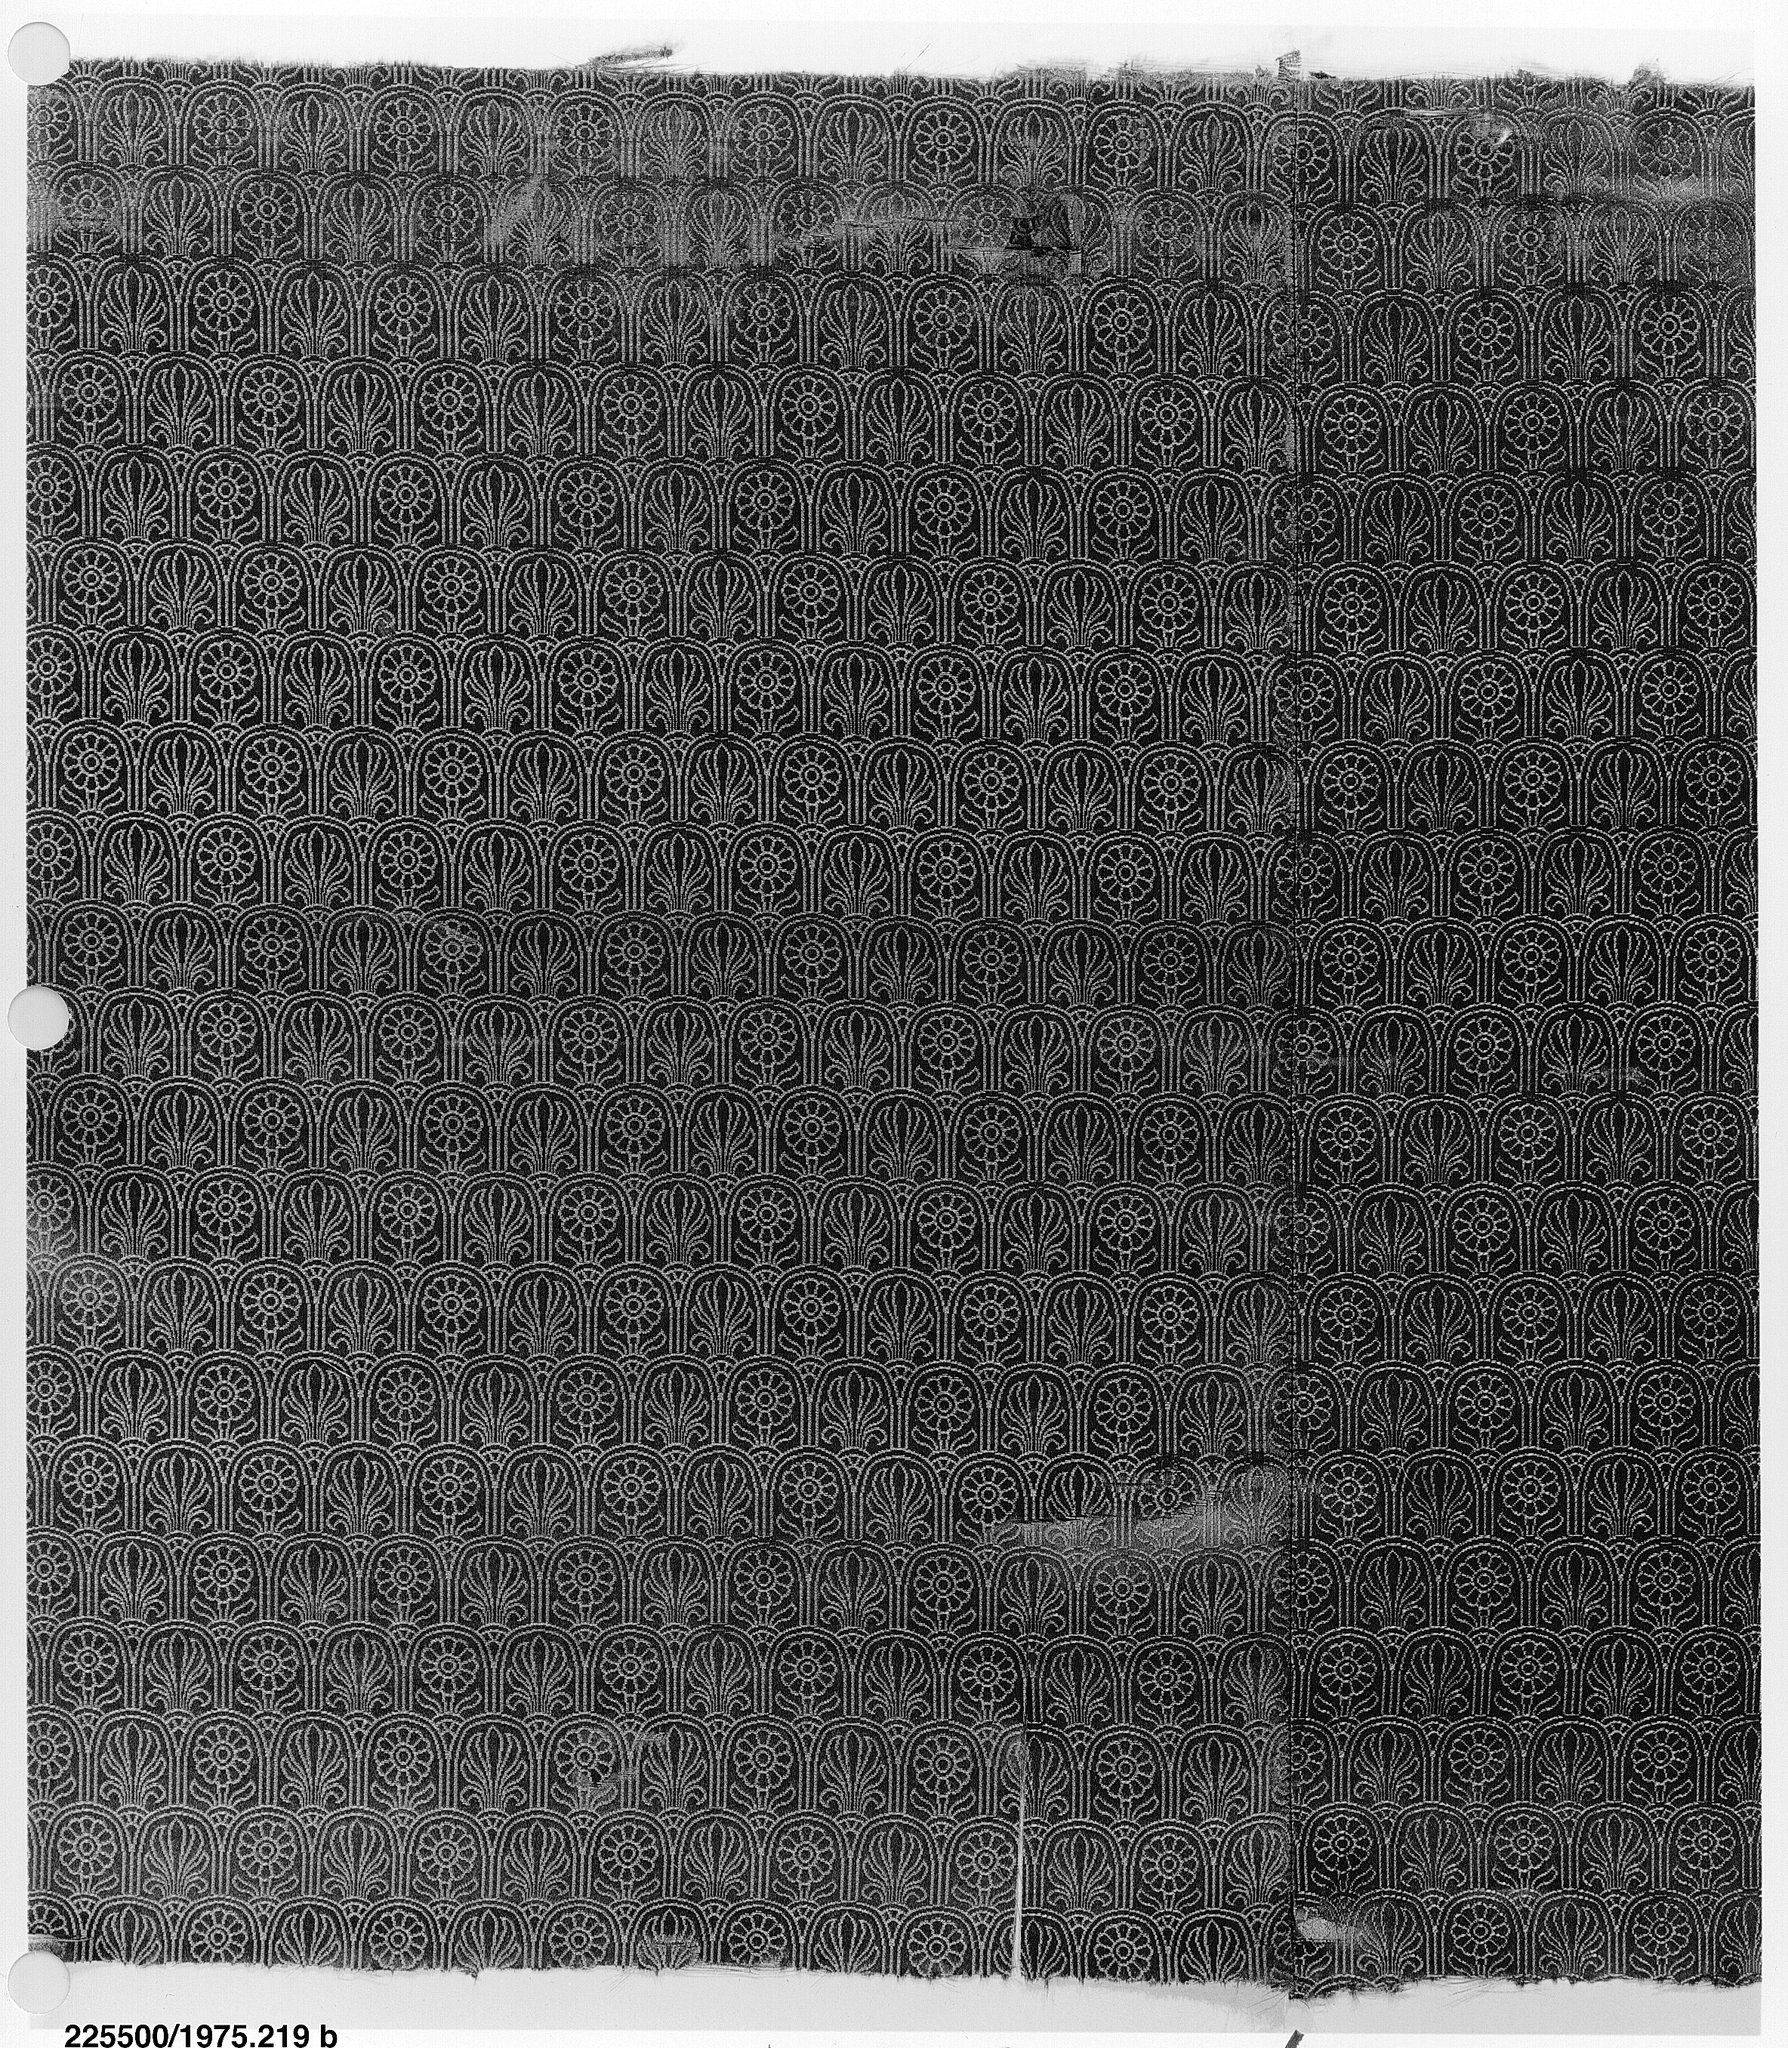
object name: upholstery panel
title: Upholstery from a settee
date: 1801-1900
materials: silk